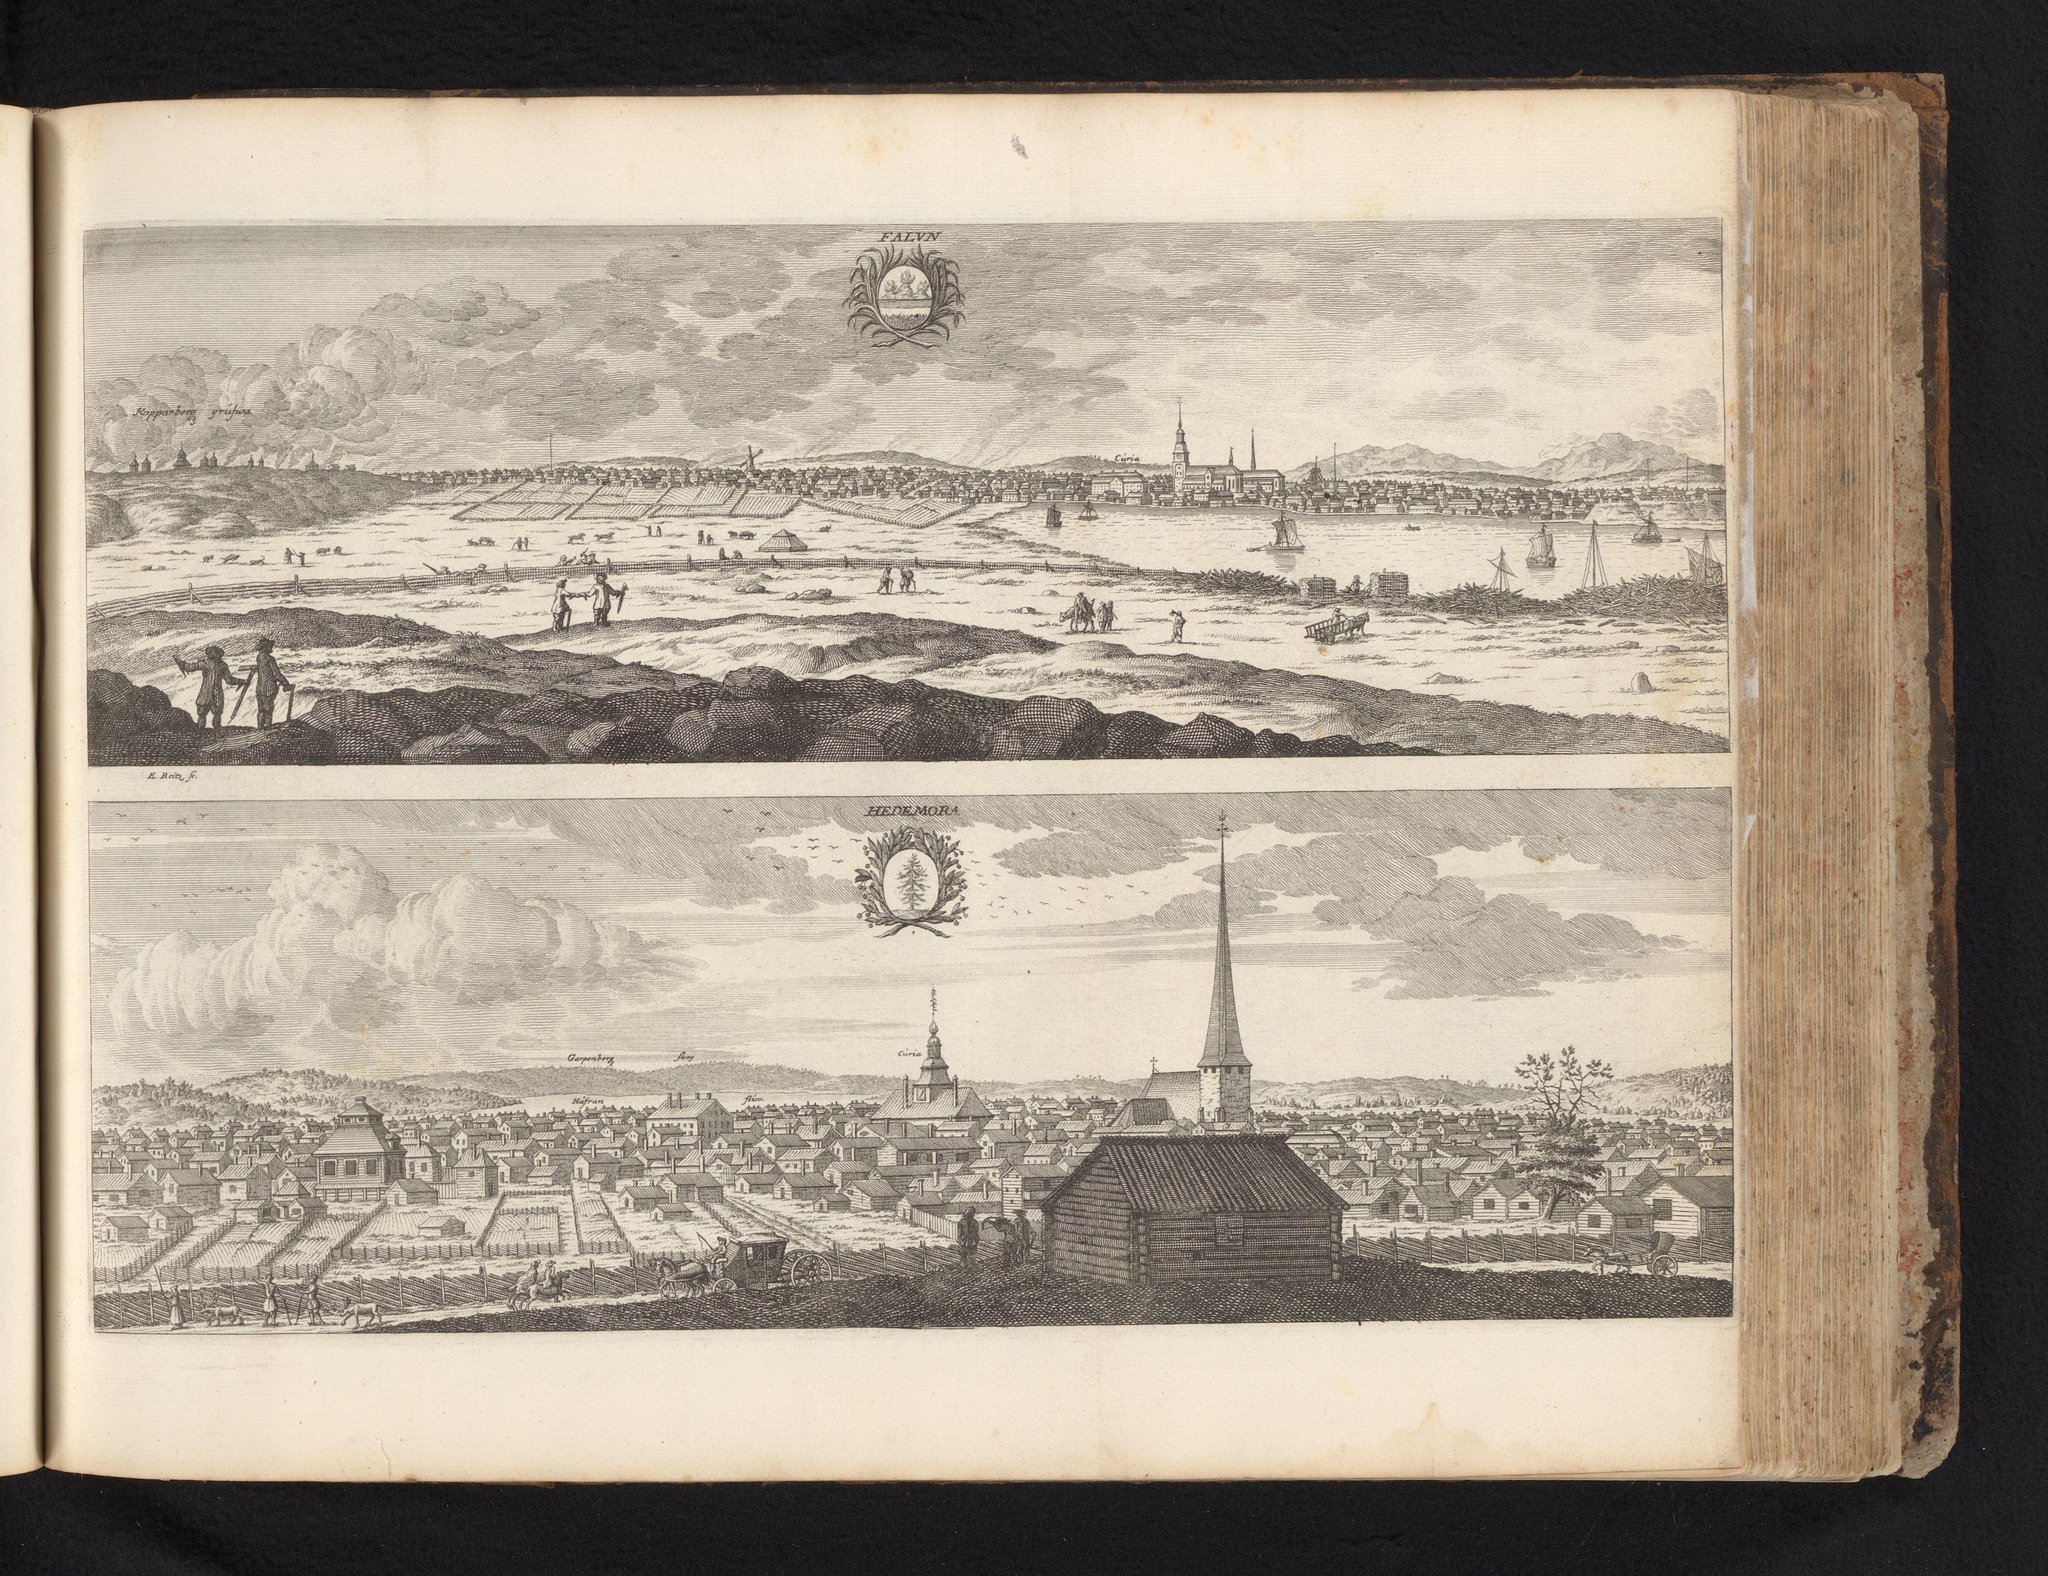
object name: print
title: Gezicht op Falun en Hedemora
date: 1696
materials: paper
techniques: etching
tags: city-view in general; 'veduta'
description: Kungliga Biblioteket, 'Suecia': http://www.kb.se/samlingarna/Kartor-bilder/Suecia-antiqua/ (geraadpleegd november 2016).